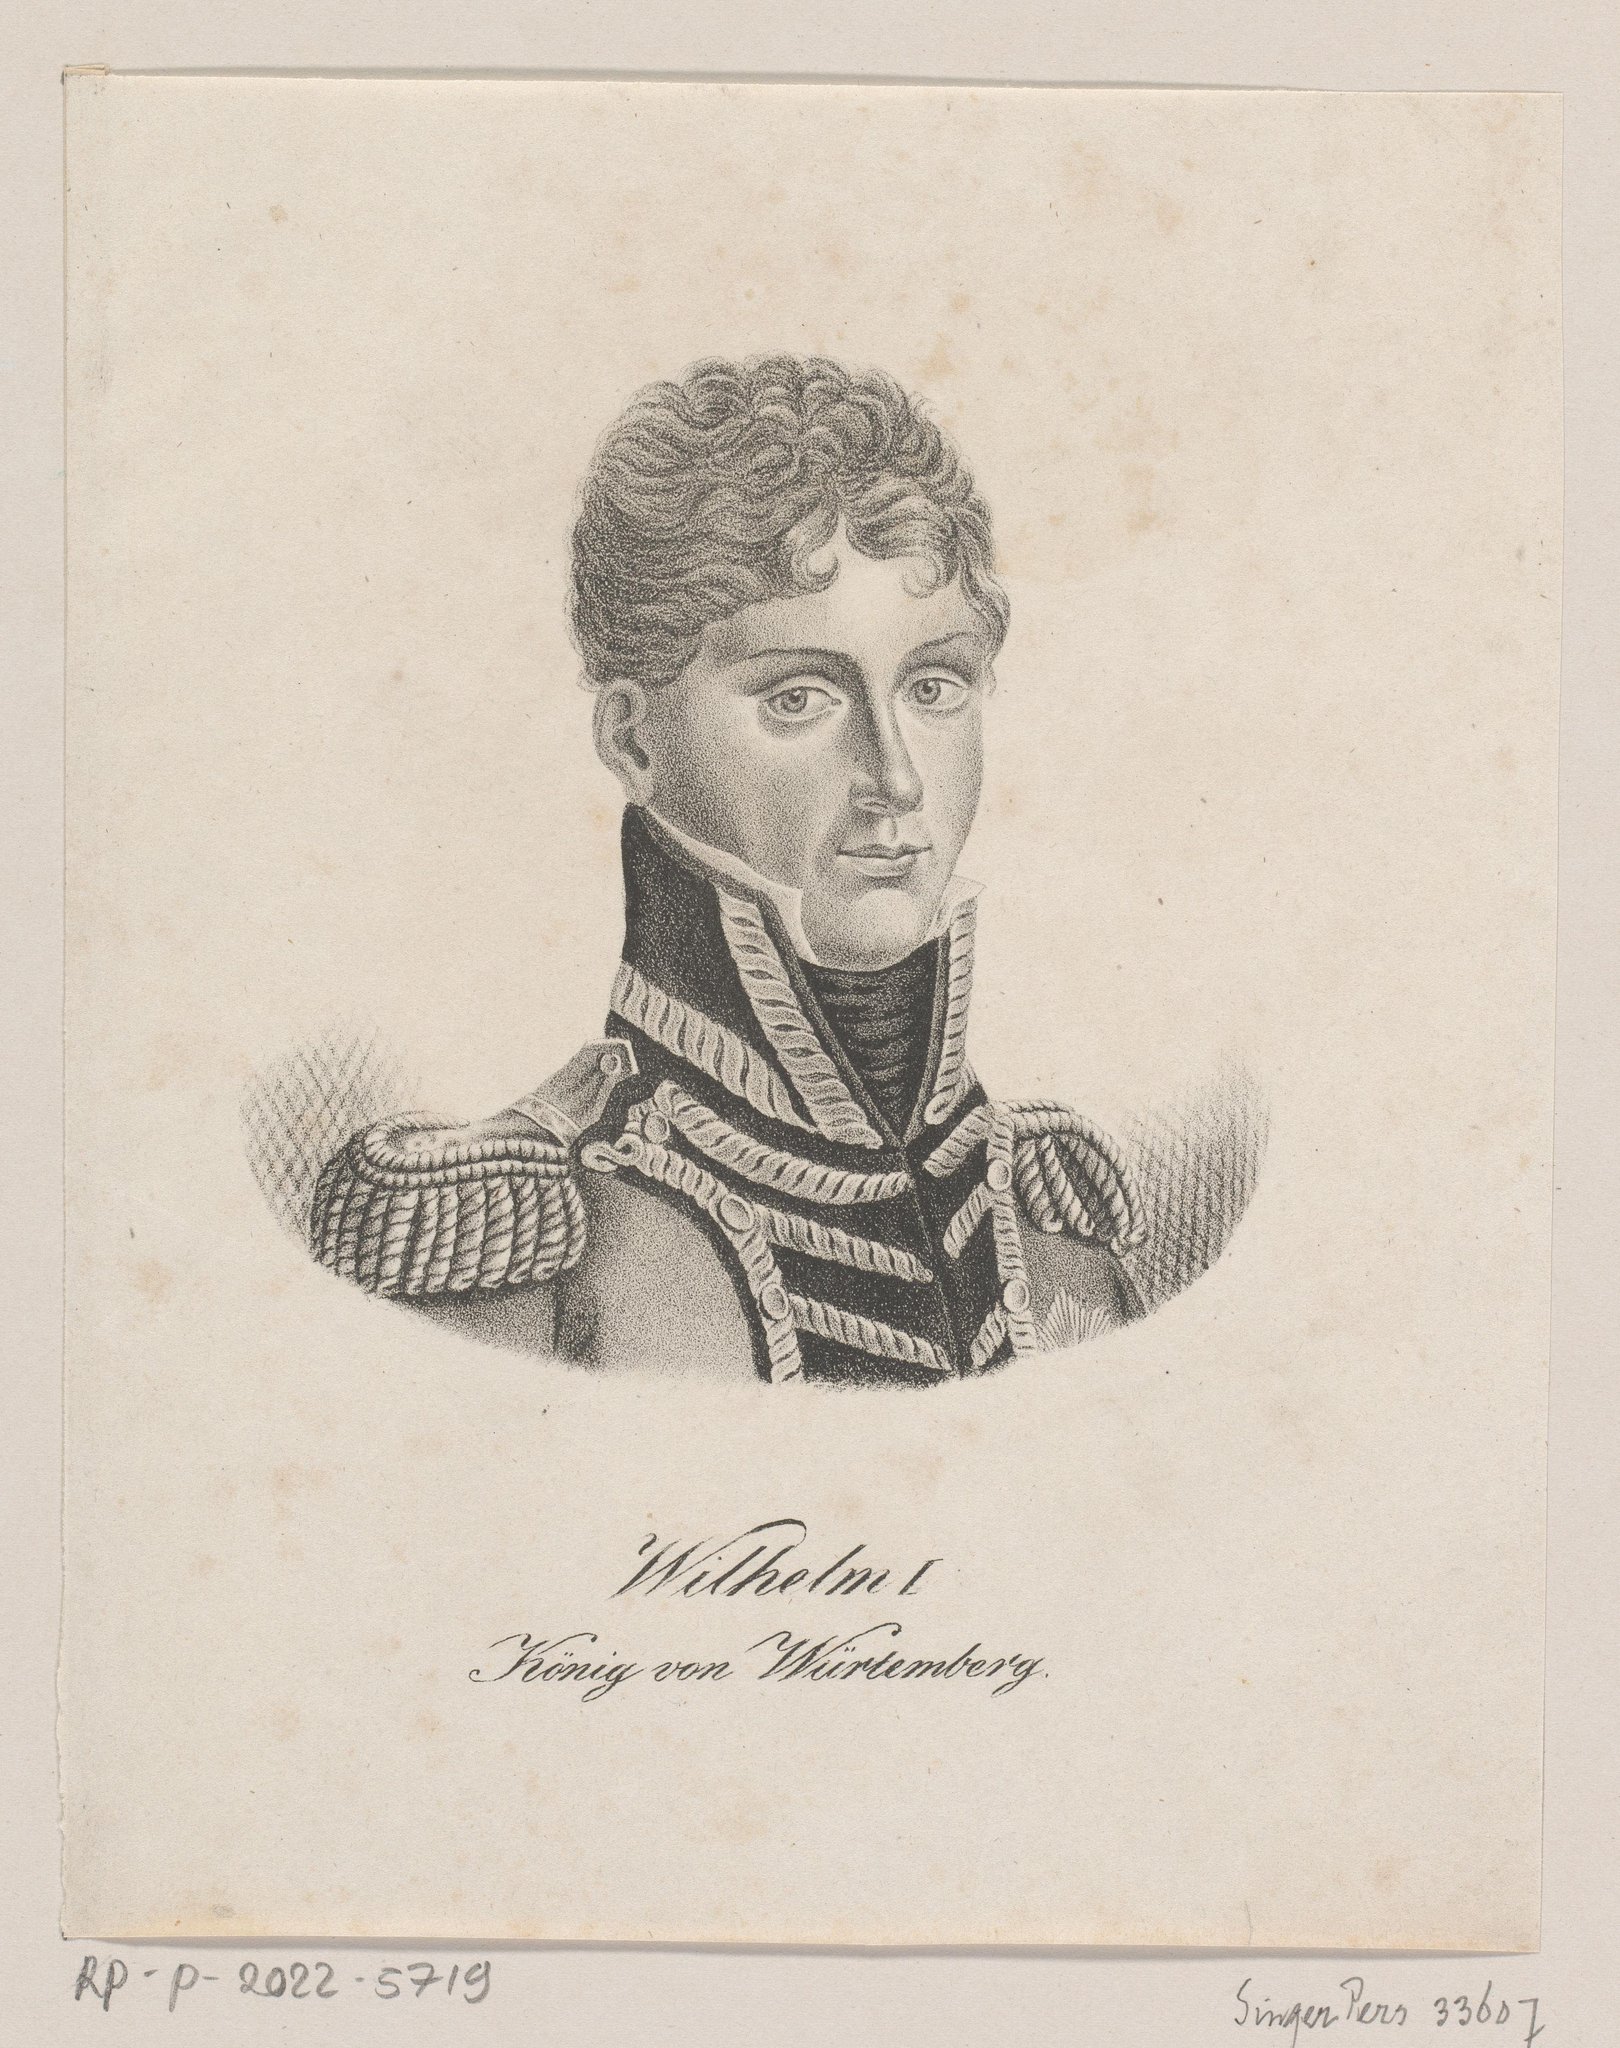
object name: print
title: Portret van Willem I, koning van Württemberg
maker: Anonymous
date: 1816-1864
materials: paper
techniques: lithograph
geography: europe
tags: willem i koning van württemberg, historical persons, king